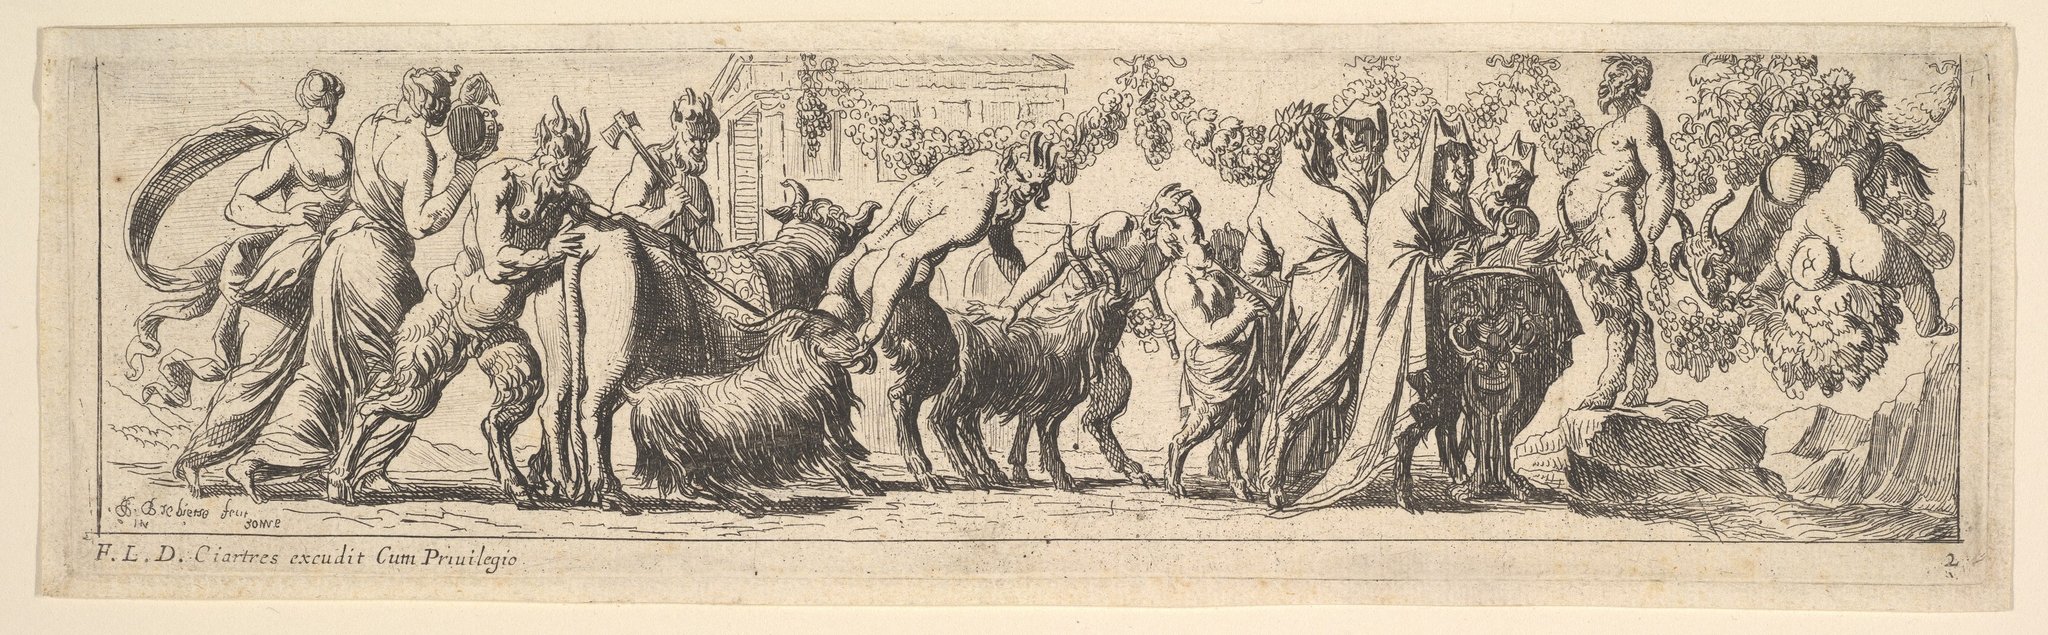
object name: print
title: Bacchanal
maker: pierre brebiette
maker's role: artist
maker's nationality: french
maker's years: 1598-1642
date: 1615-1642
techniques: etching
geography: france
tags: human figures,animals